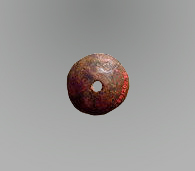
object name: disk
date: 600-401 BCE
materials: amber